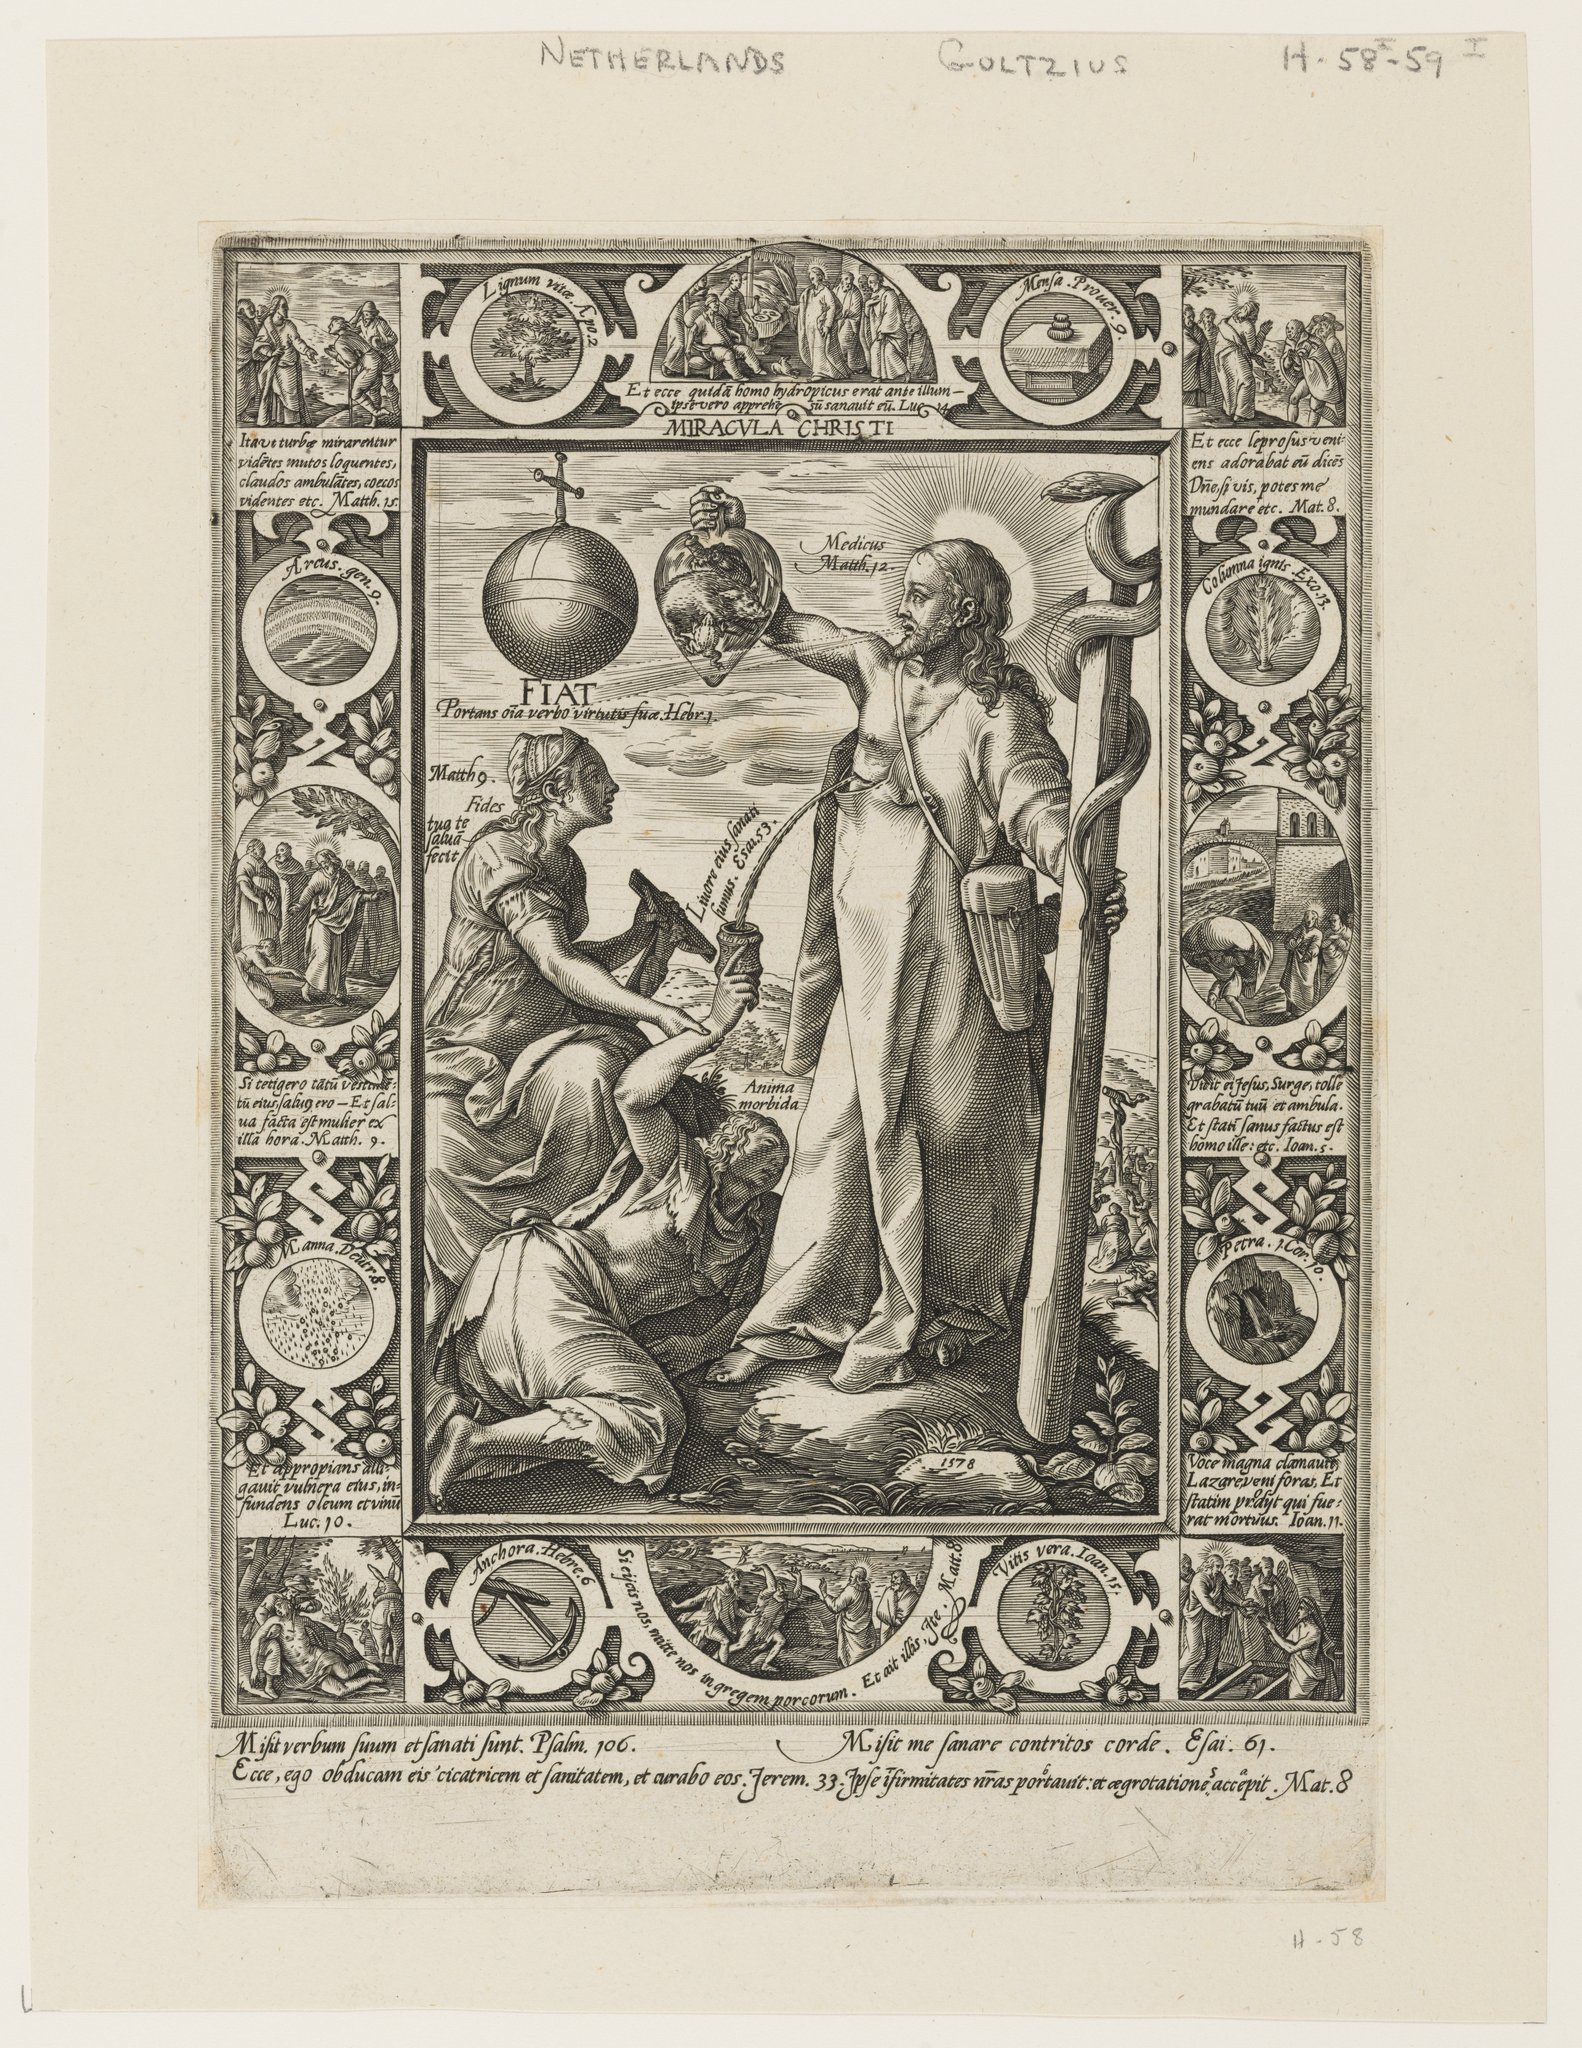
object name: print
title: The Miraculous Healings of Christ, from "Allegories Based on the Life of Christ"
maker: hendrick goltzius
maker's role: artist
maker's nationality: netherlandish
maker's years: 1558-1617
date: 1578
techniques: engraving